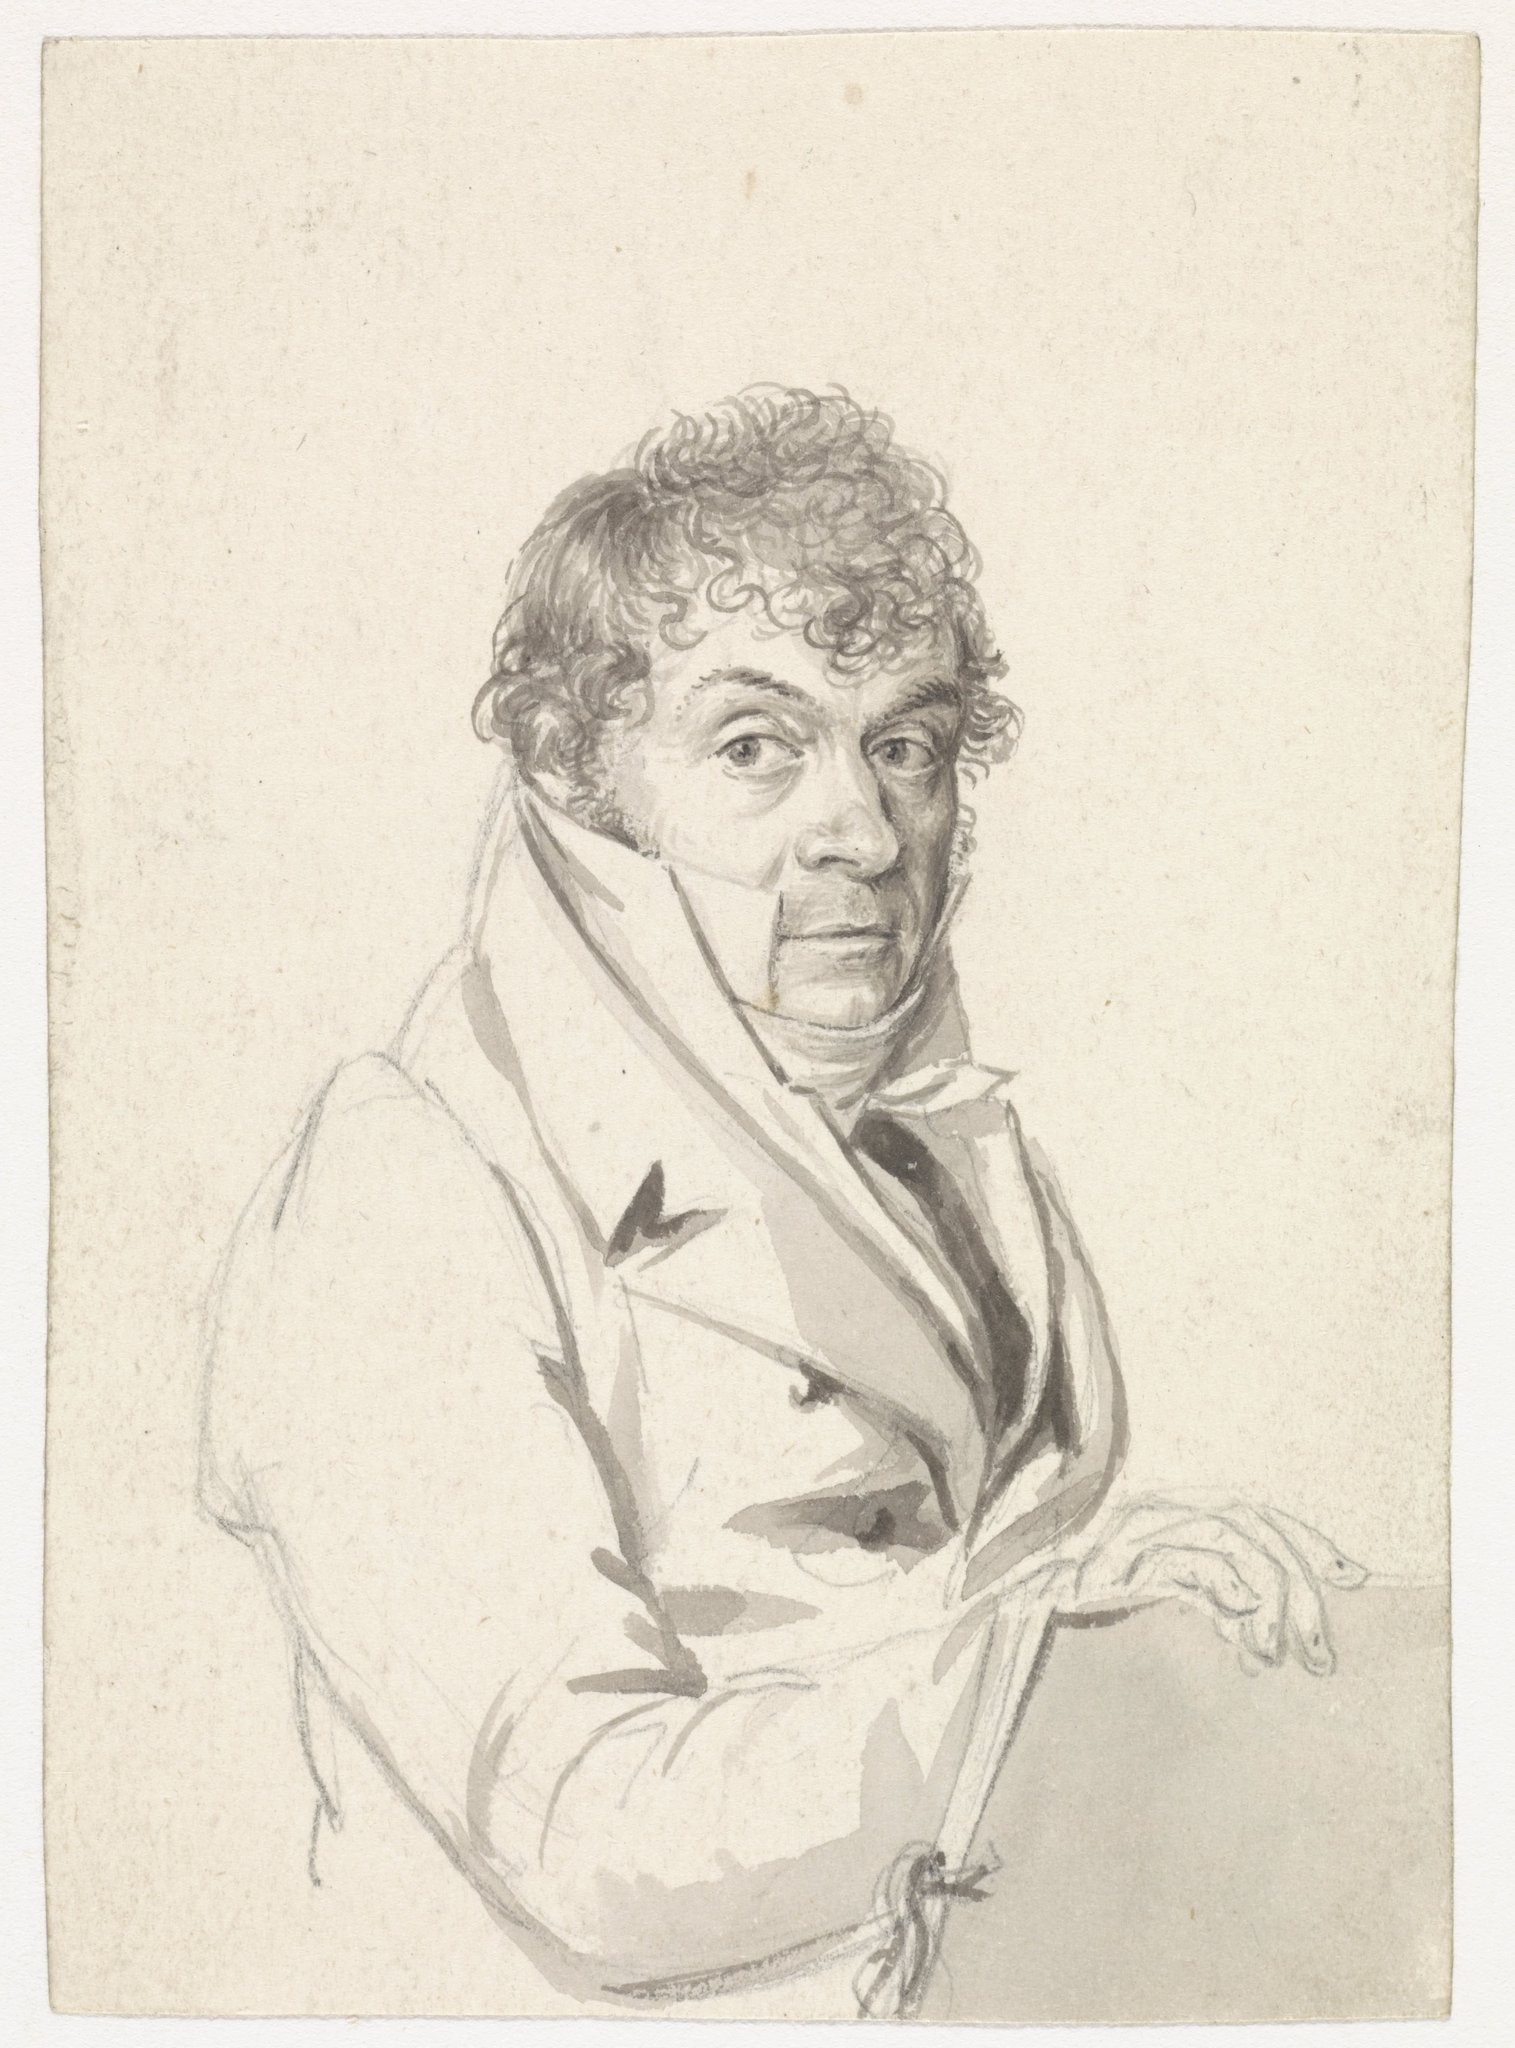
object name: drawing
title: Portret van André Burnier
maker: hendrik willem caspari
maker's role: draughtsman, print maker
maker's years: 1770-1829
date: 1780-1829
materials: paper, pencil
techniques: brush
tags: historical persons, portrait, self-portrait of painter, portrait, self-portrait of artist, portrait, self-portrait of draughtsman